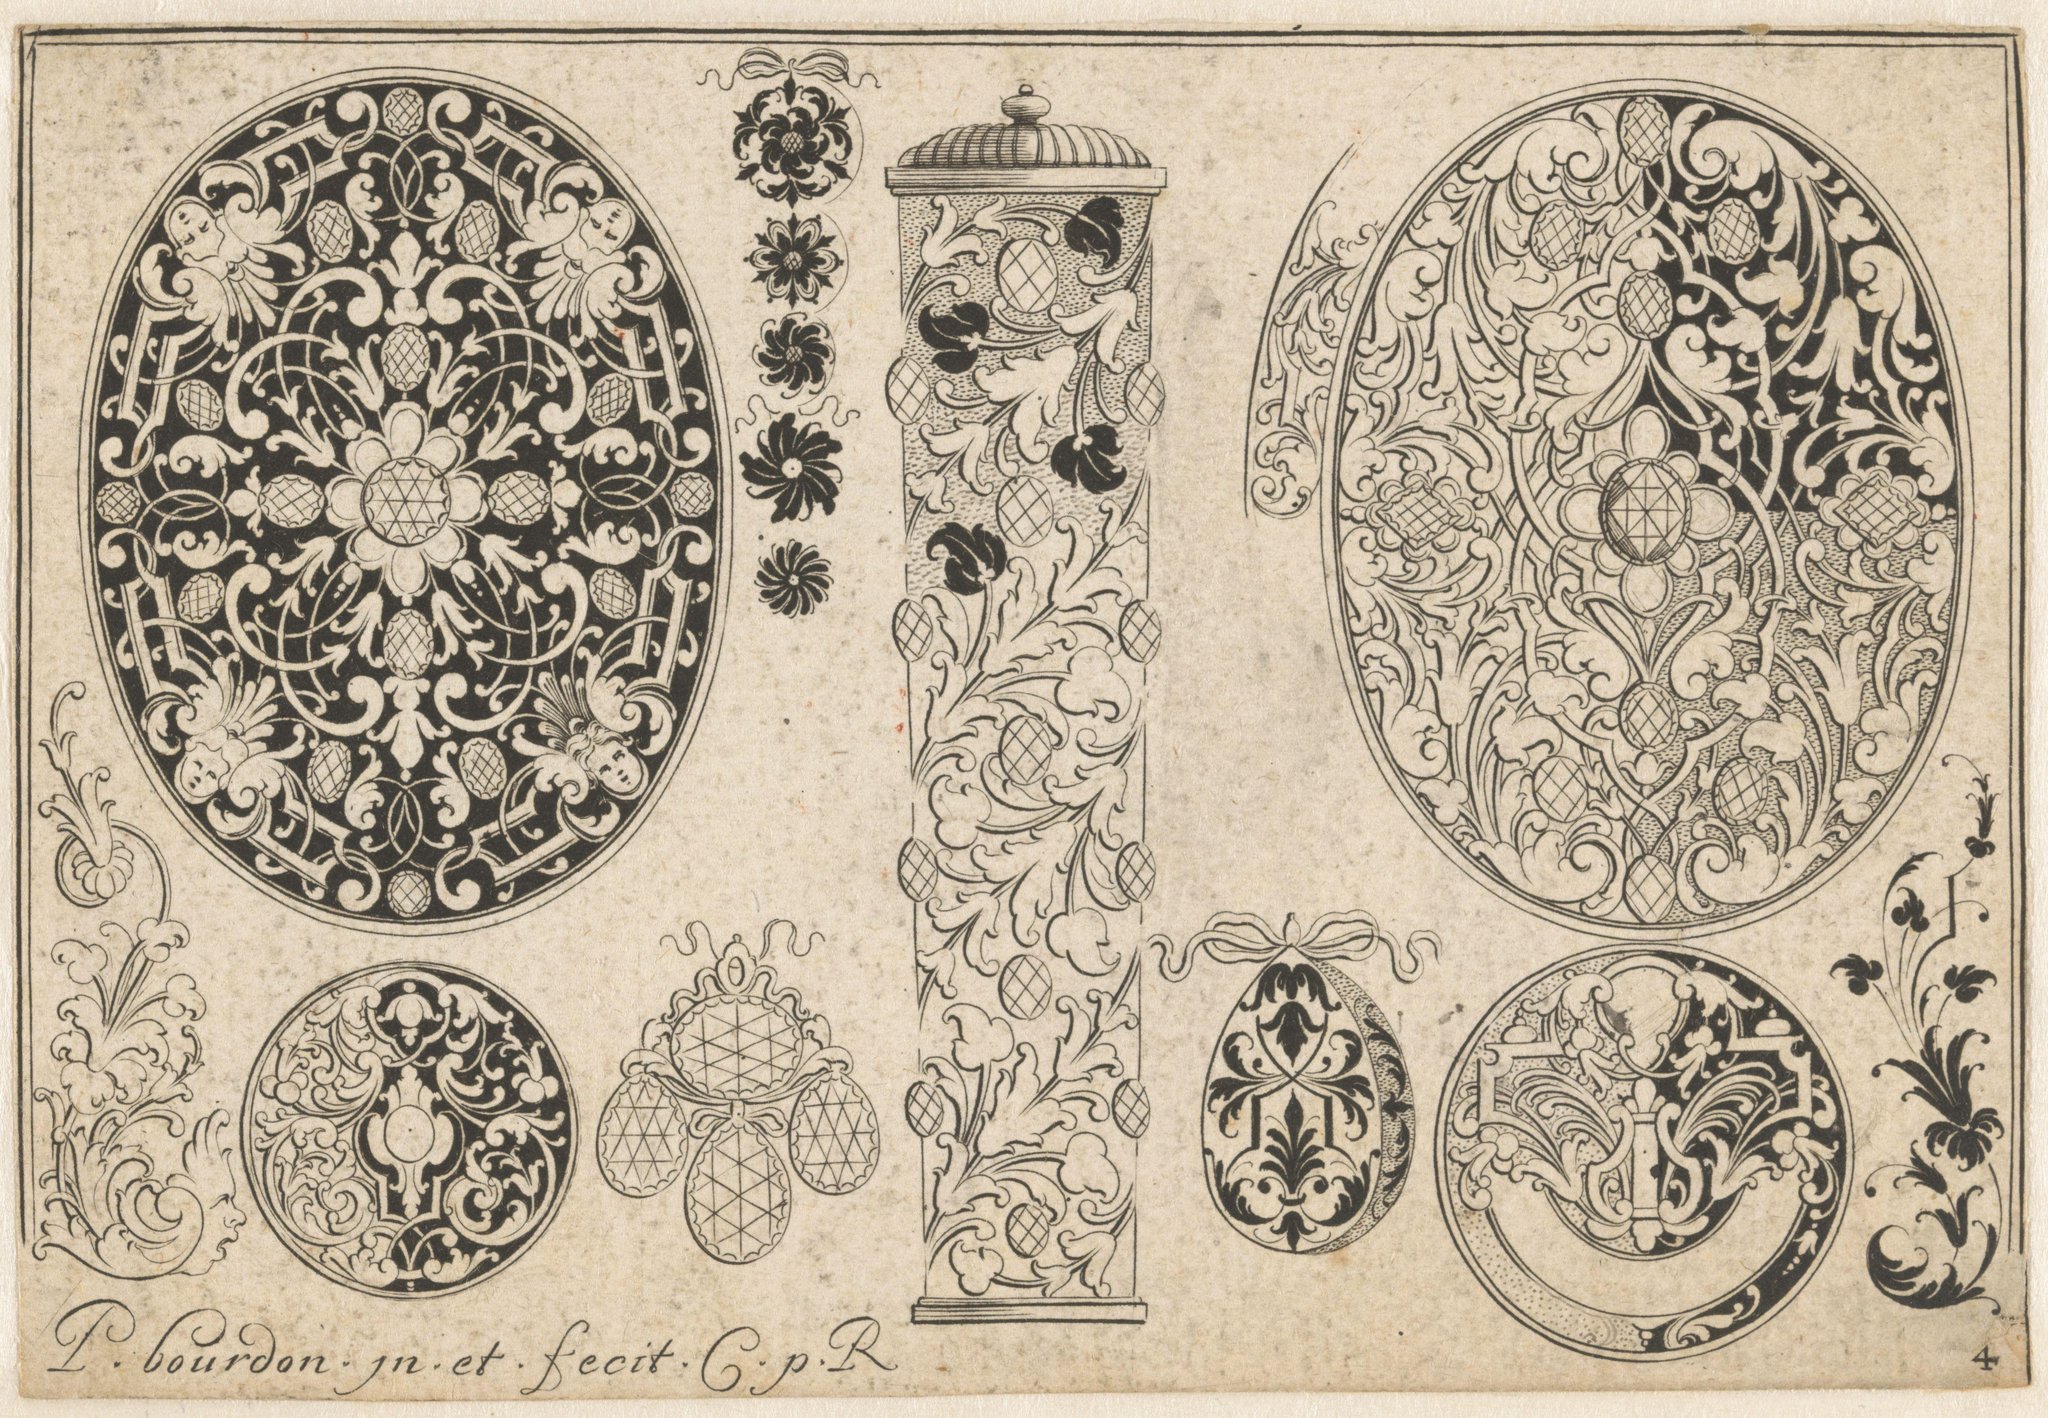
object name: ornament print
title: Livre Troisieme: Essais de gravure par Pierre Bourdon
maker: pierre bourdon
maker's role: print maker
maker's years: 1656-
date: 1703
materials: paper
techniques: engraving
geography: paris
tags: ornaments ~ art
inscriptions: signature: ‘P. bourdon in et fecit’, collector's mark: Lugt 2760, number: ‘4’, privilege: ‘C. p. R’, collector's mark: Lugt 2228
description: Blad uit serie van zeven van ontwerpen voor horlogemakers, goudsmeden, beeldhouwers en graveurs.